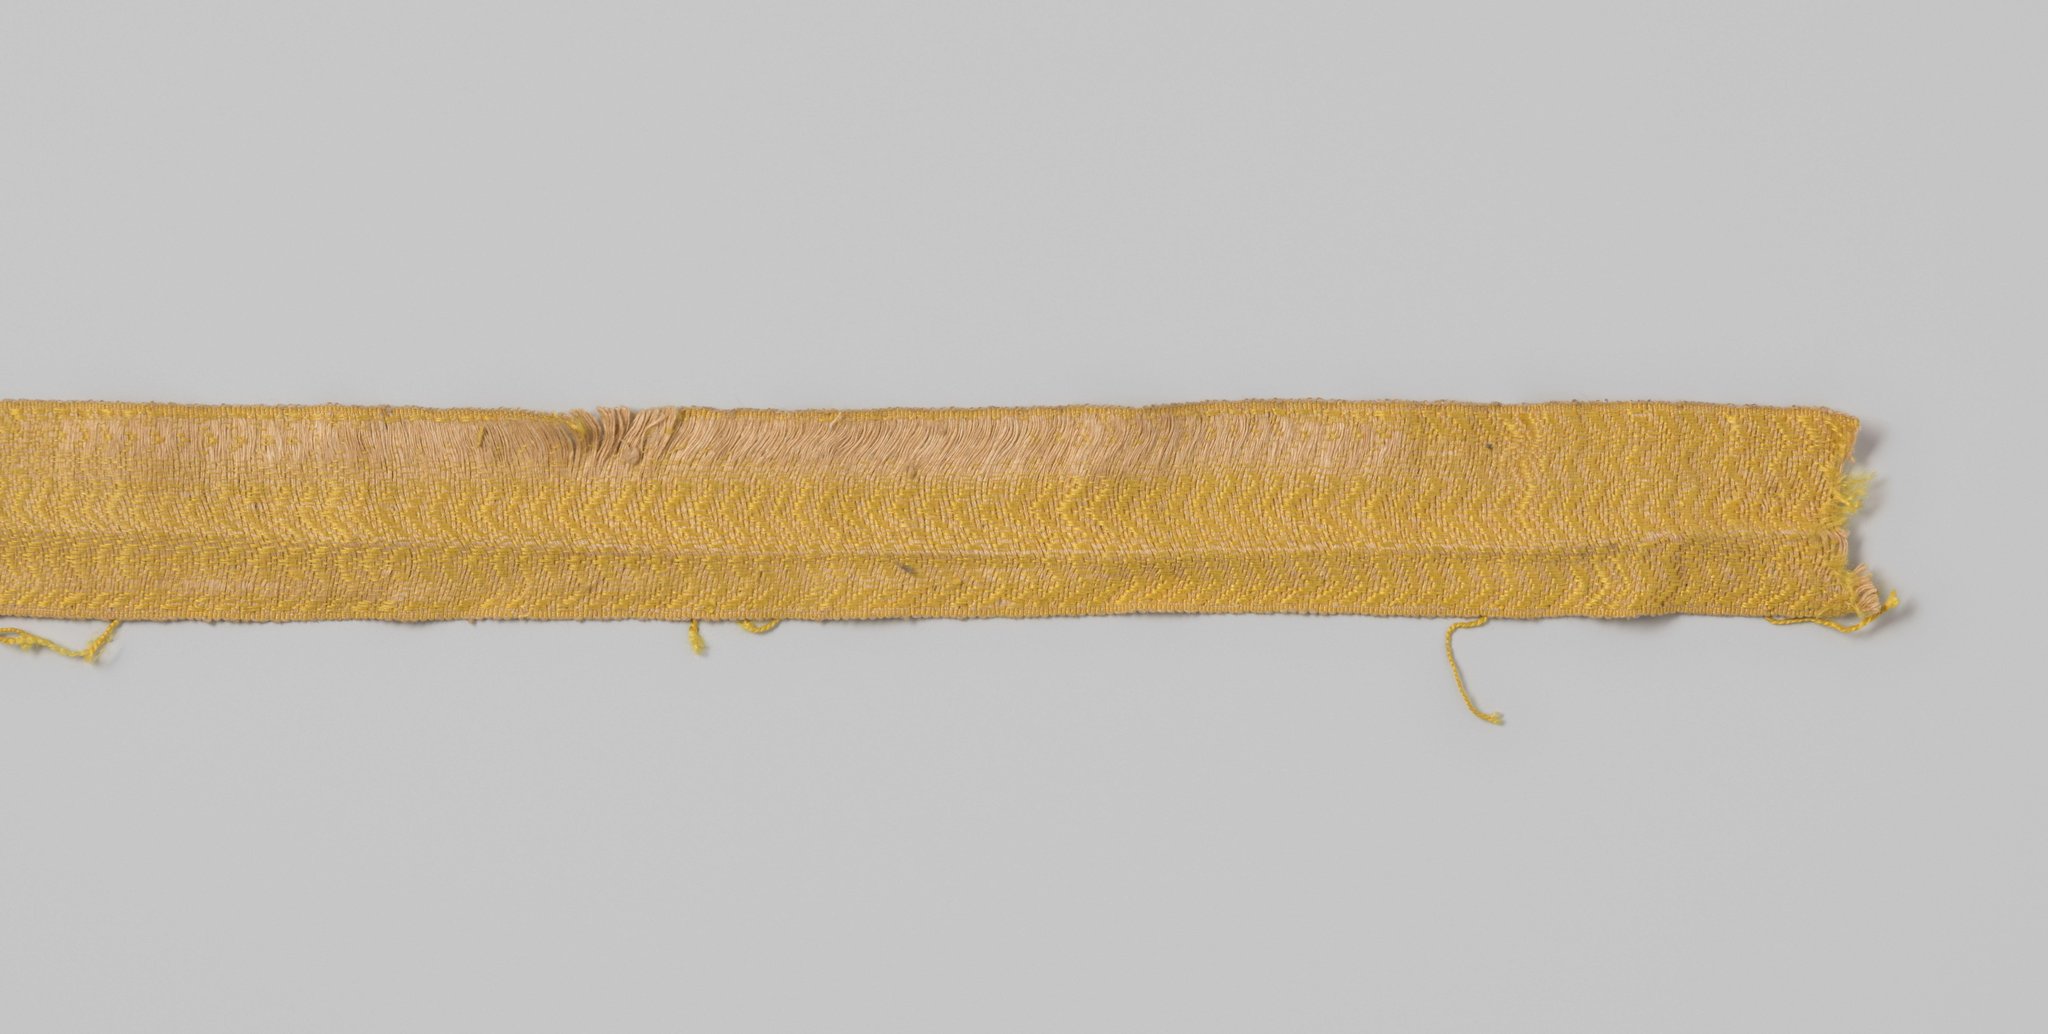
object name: braid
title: Passement van linnen en gele zijde in zigzagpatroon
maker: Anonymous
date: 1700-1899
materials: linen, silk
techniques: weave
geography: europe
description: Passement van linnen en gele zijde in een patroon van evenwijdige lijnen in een zigzagpatroon. Object overeenkomstig met BK-NM-12186-22.